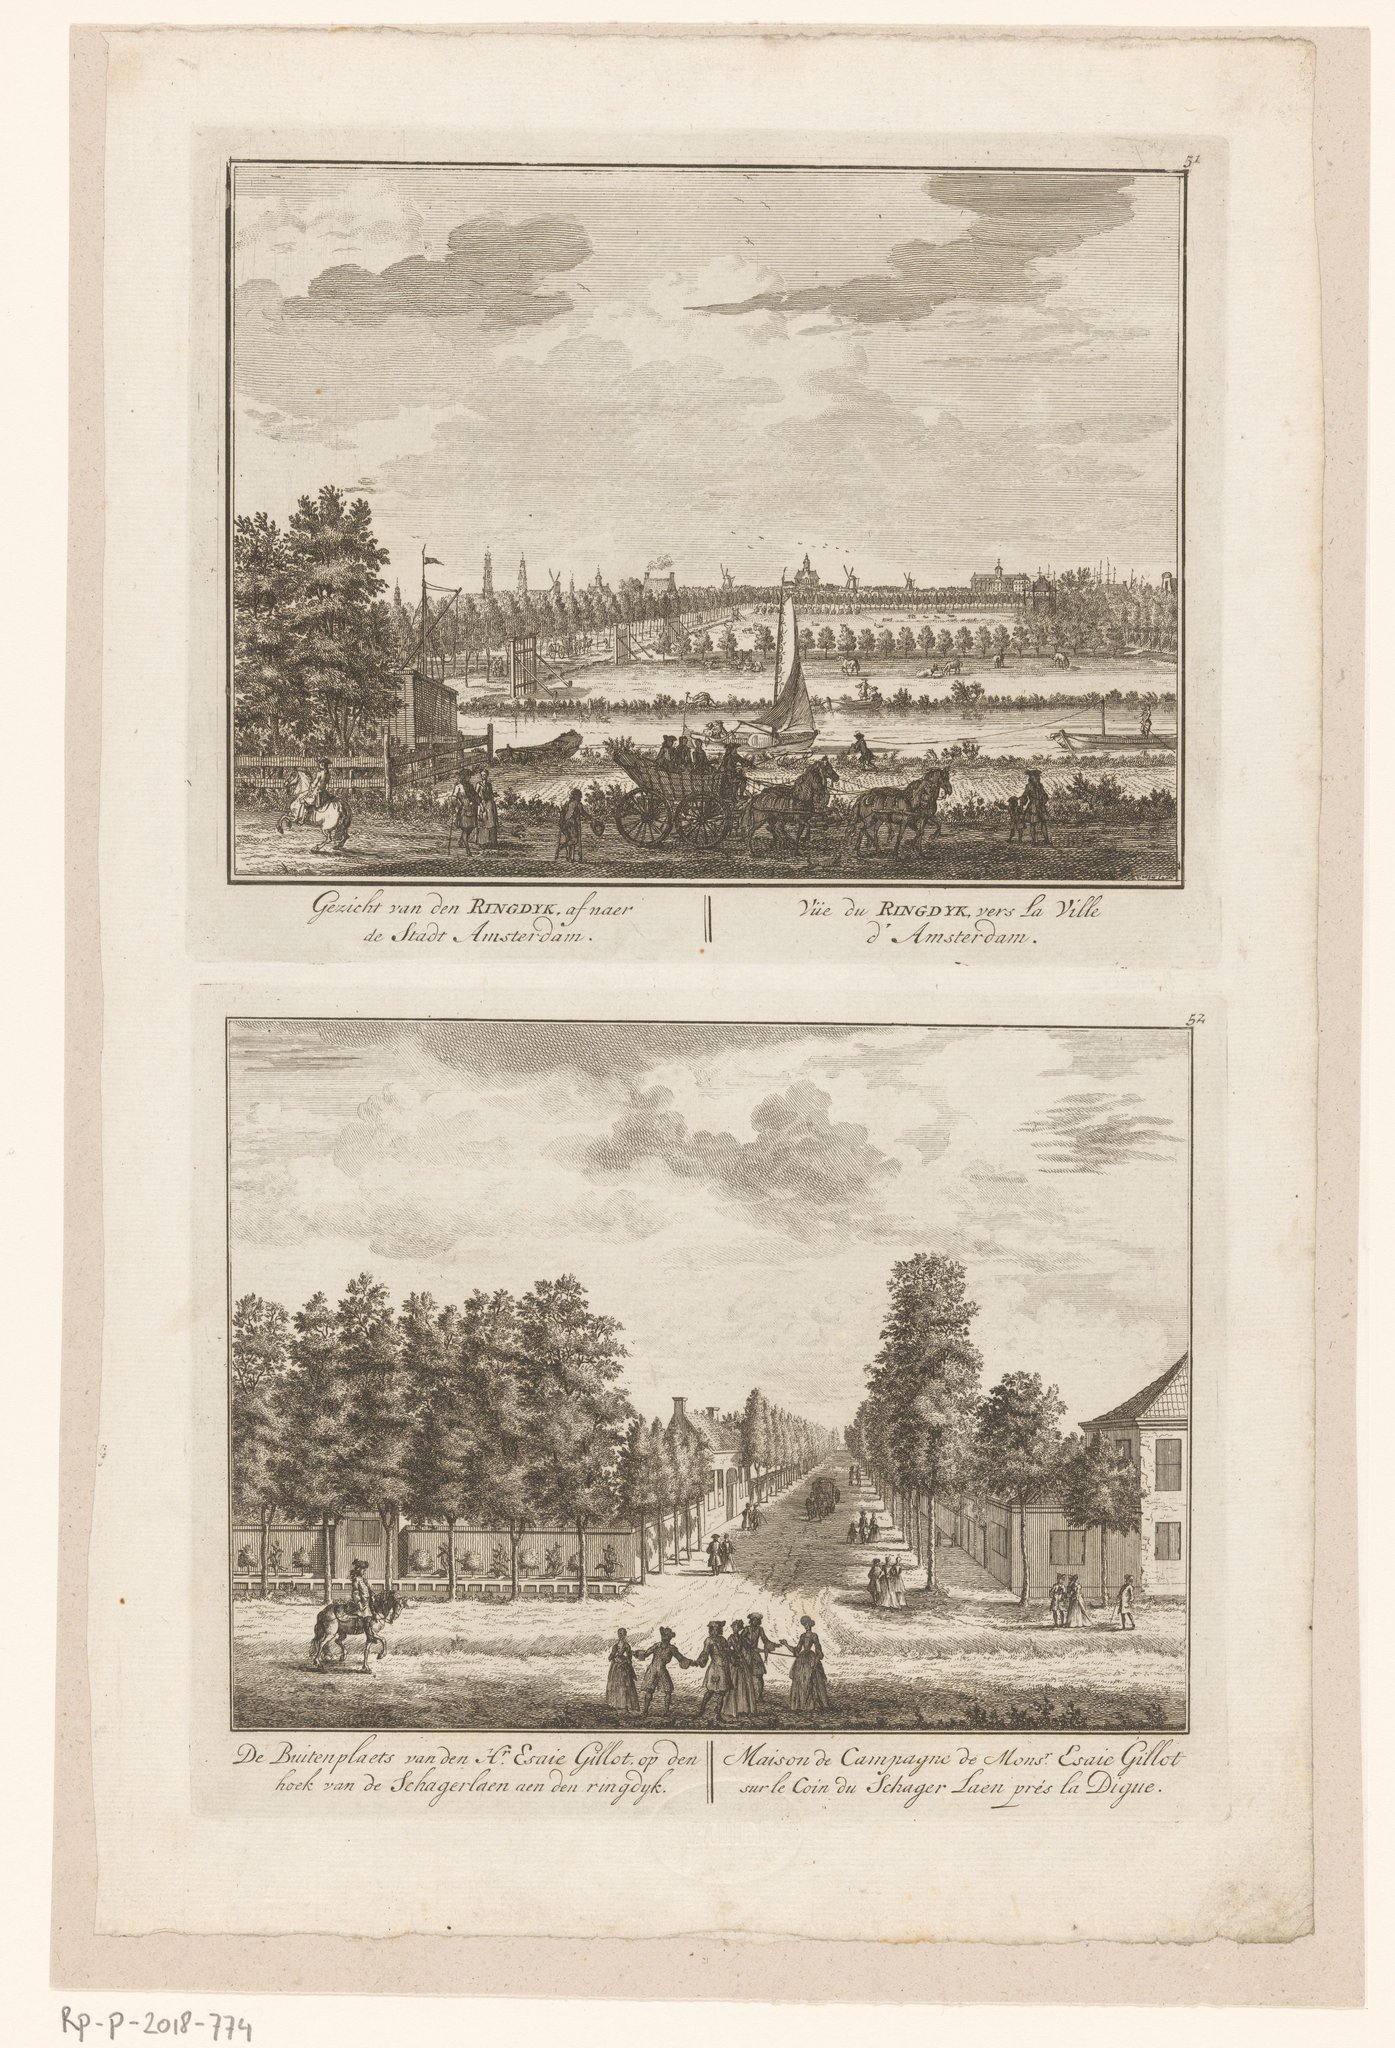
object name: book illustration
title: De buitenplaets van den hr. Esaie Gillot, op den hoek van de (...) / Maison de campagne de monsr. Esaie Gillot sur le coin du (...)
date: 1725-1768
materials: paper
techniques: engraving, etching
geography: amsterdam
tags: french or architectonic garden; formal garden, prospect of city, town panorama, silhouette of city, country-house, amsterdam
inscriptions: check stamp: ‘Archief Ministerie van Oorlog Afdeeling Genie’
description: Prent gebruikt in: Niedek, Mattaeus Brouërius. Het verheerlykt Watergraafs- of Diemermeer by de stadt Amsterdam (...). Amsterdam: Andries en Hendrik de Leth, 1725. Of in: Niedek, Mattaeus Brouërius. Het verheerlykt Watergraafs- of Diemermeer by de stadt Amsterdam (...). Amsterdam: Pieter Jan Entrop, 1768.